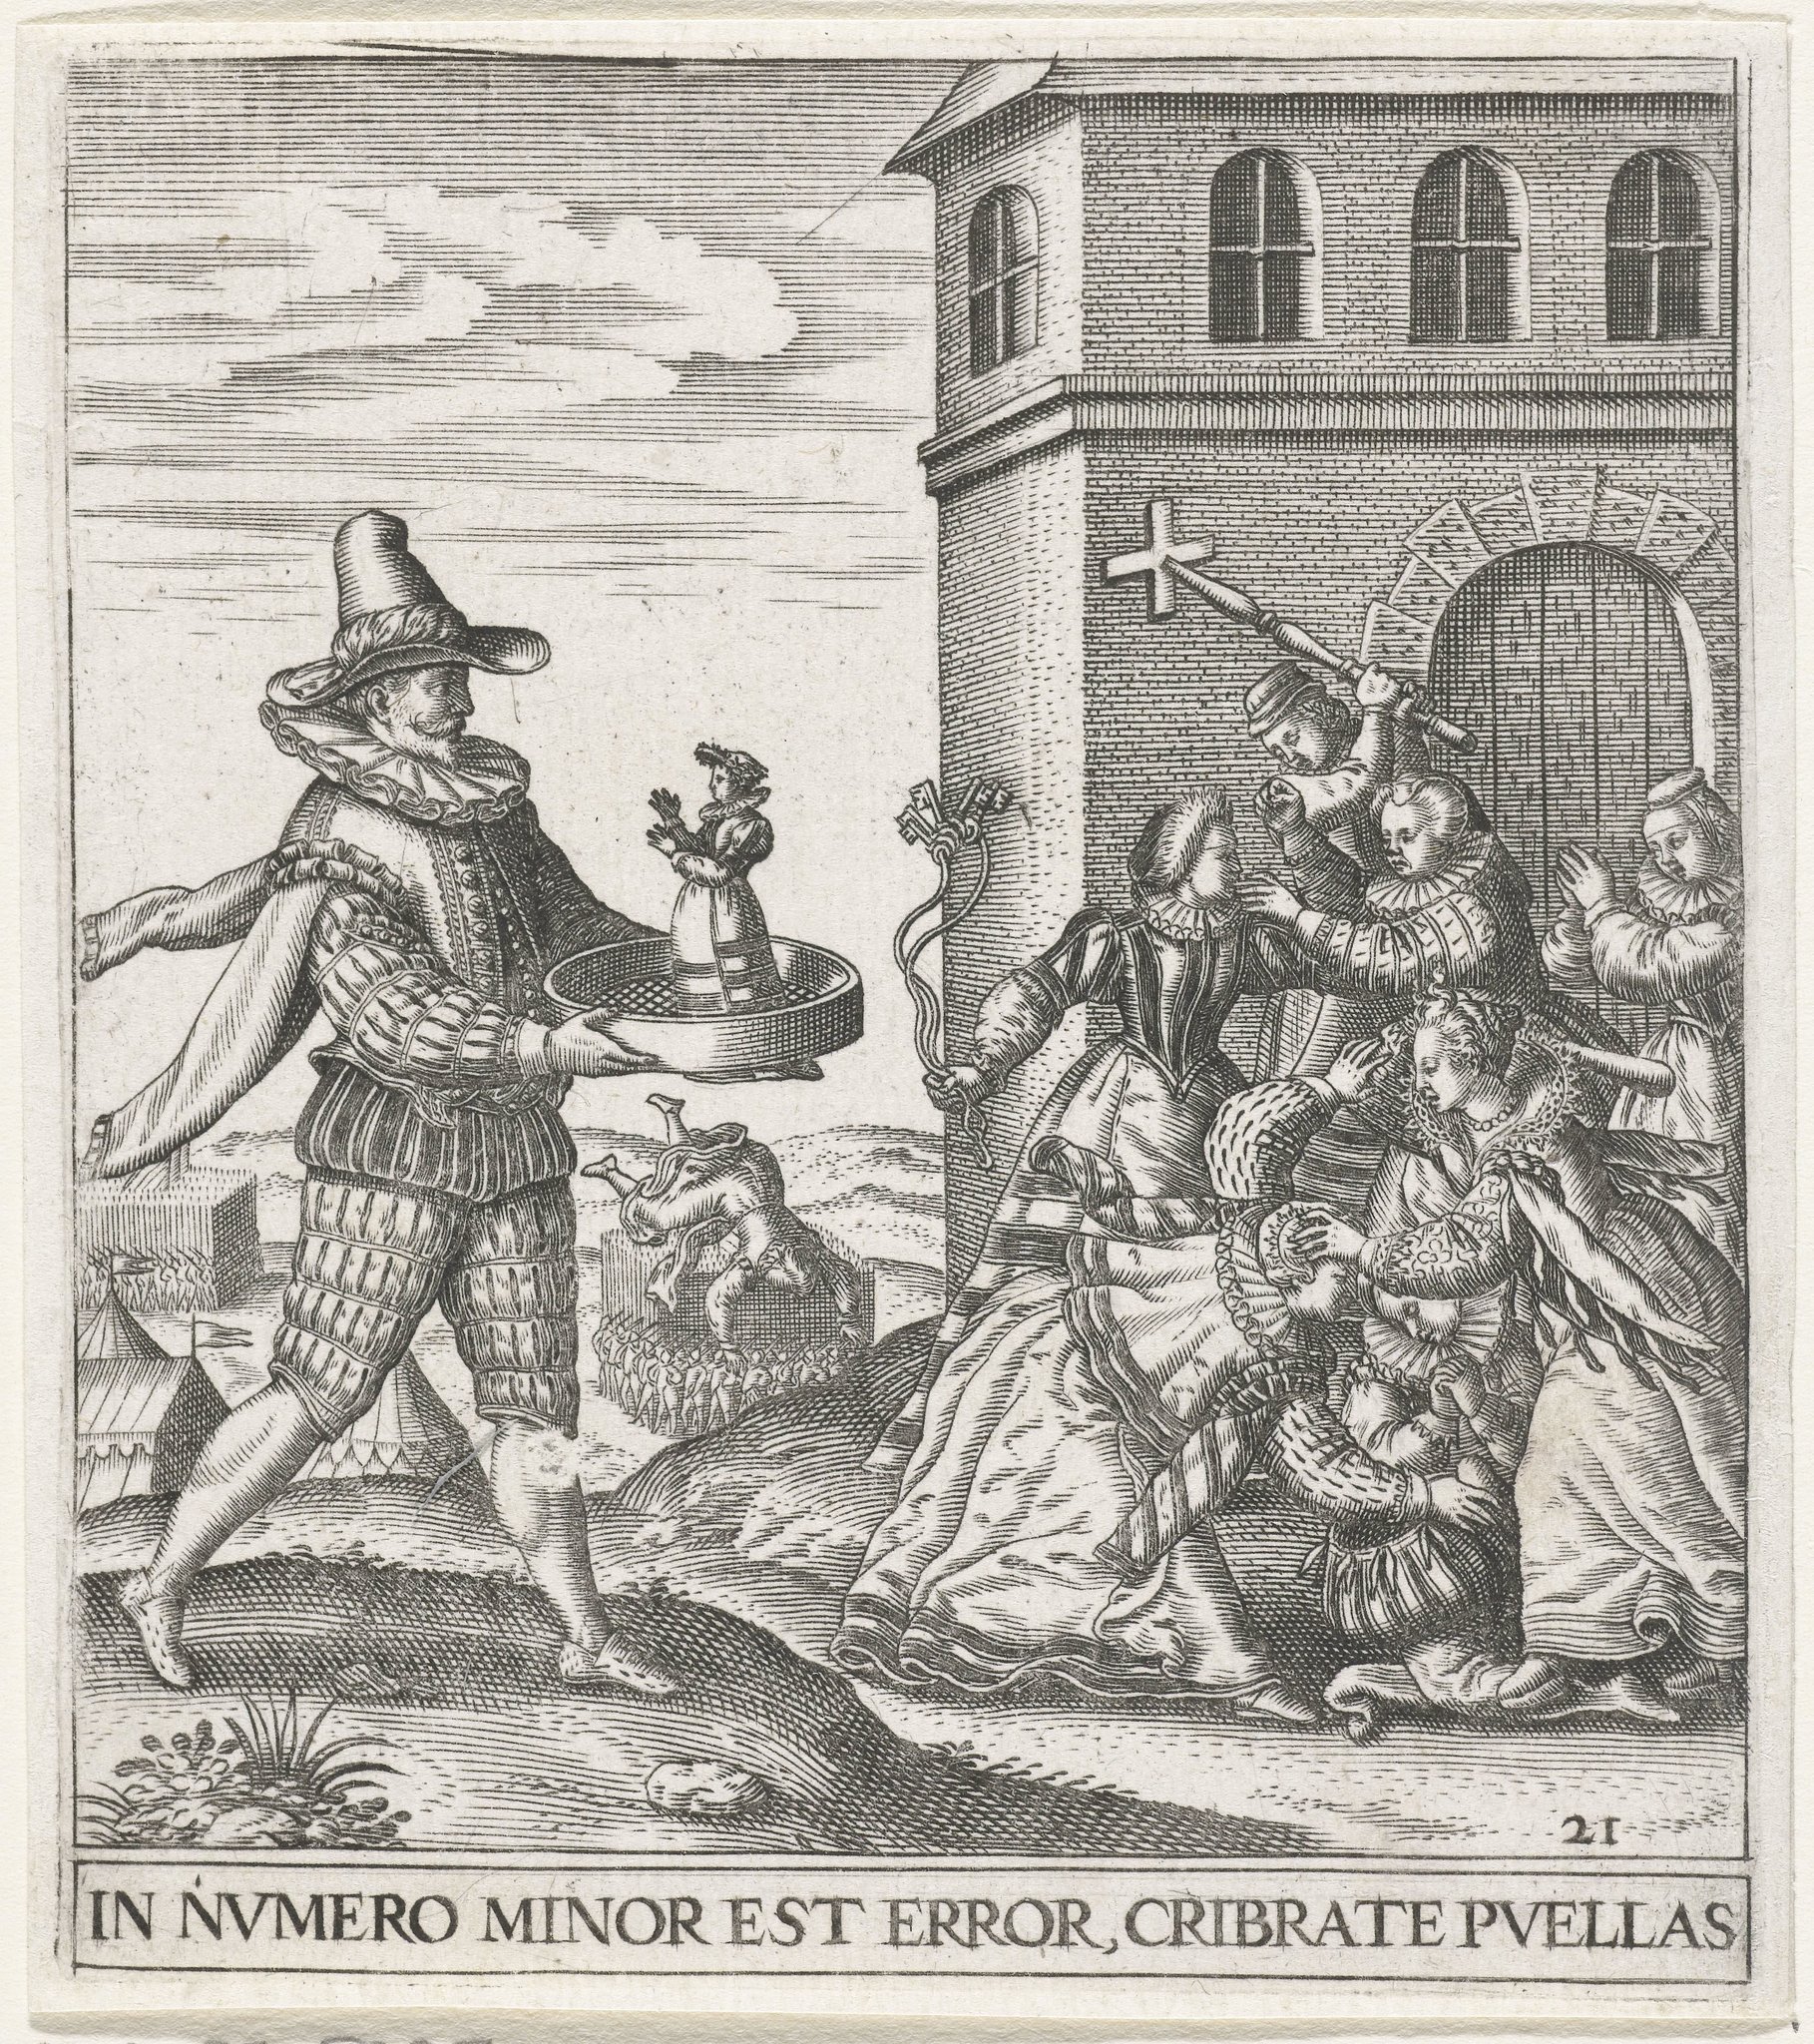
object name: print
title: IN NVMERO MINOR EST ERROR, CRIBRATE PUELLAS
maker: johann theodor de bry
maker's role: print maker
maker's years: 1561-1623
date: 1596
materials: paper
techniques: engraving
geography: frankfurt am main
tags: existence and modes of existence (+ emblematical representation of concept), rivalry of men for the love of a woman; trying to get the skirt; 'rivalità' (ripa) - cc - pursuit of a man, sifting out the candidates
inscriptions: number: ‘21’, collector's mark: Lugt 240, inscription: ‘IN NUMERO MINOR EST ERROR, CRIBRATE PUELLAS’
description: Bespotting van de grote behoefte aan mannen. De vrouwen doen van alles om er een te krijgen, ze vechten er zelfs om. Zes vrouwen gaan elkaar te lijf en vechten om een mannenboek. De man, linksvoor, verkeert in een gunstige positie: hij kan vrouwen krijgen te kust en te keur. Hij zeeft ze in een grote platte zeef, zodat hij de beste overhoudt. Deze zal hij trouwen. Embleem nr. 21 in Emblemata Saecularia, 1596 en nr. 42 in de tweede uitgave van 1611.